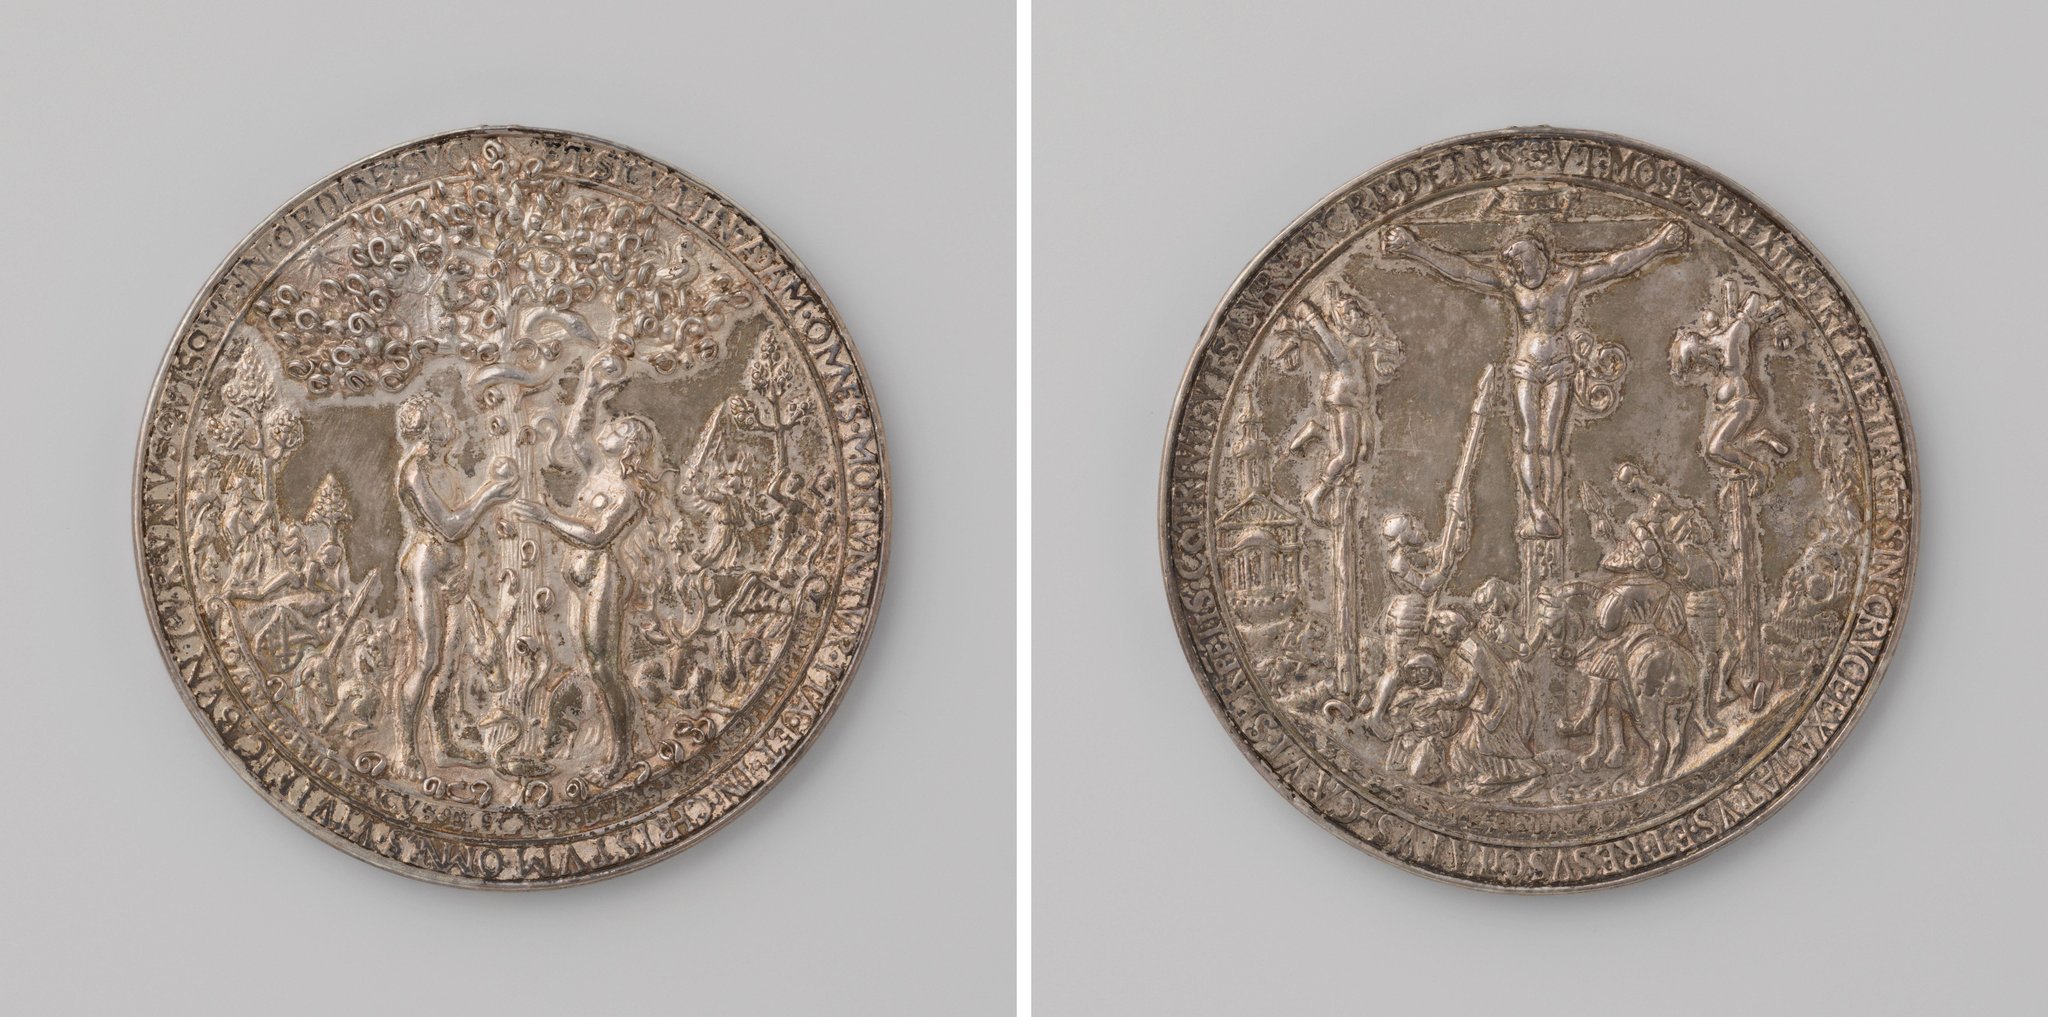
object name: history medal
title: Zondeval en kruisiging, penning geslagen op last van Johan Frederik de Grootmoedige, keurvorst van Saksen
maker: hans reinhart (der ältere)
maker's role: medailleur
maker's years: 1510-1581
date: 1536-1607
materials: silver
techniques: casting, metalworking, engraving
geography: leipzig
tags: torgau, weimar, keurvorst, johan frederik i (keurvorst van saksen)